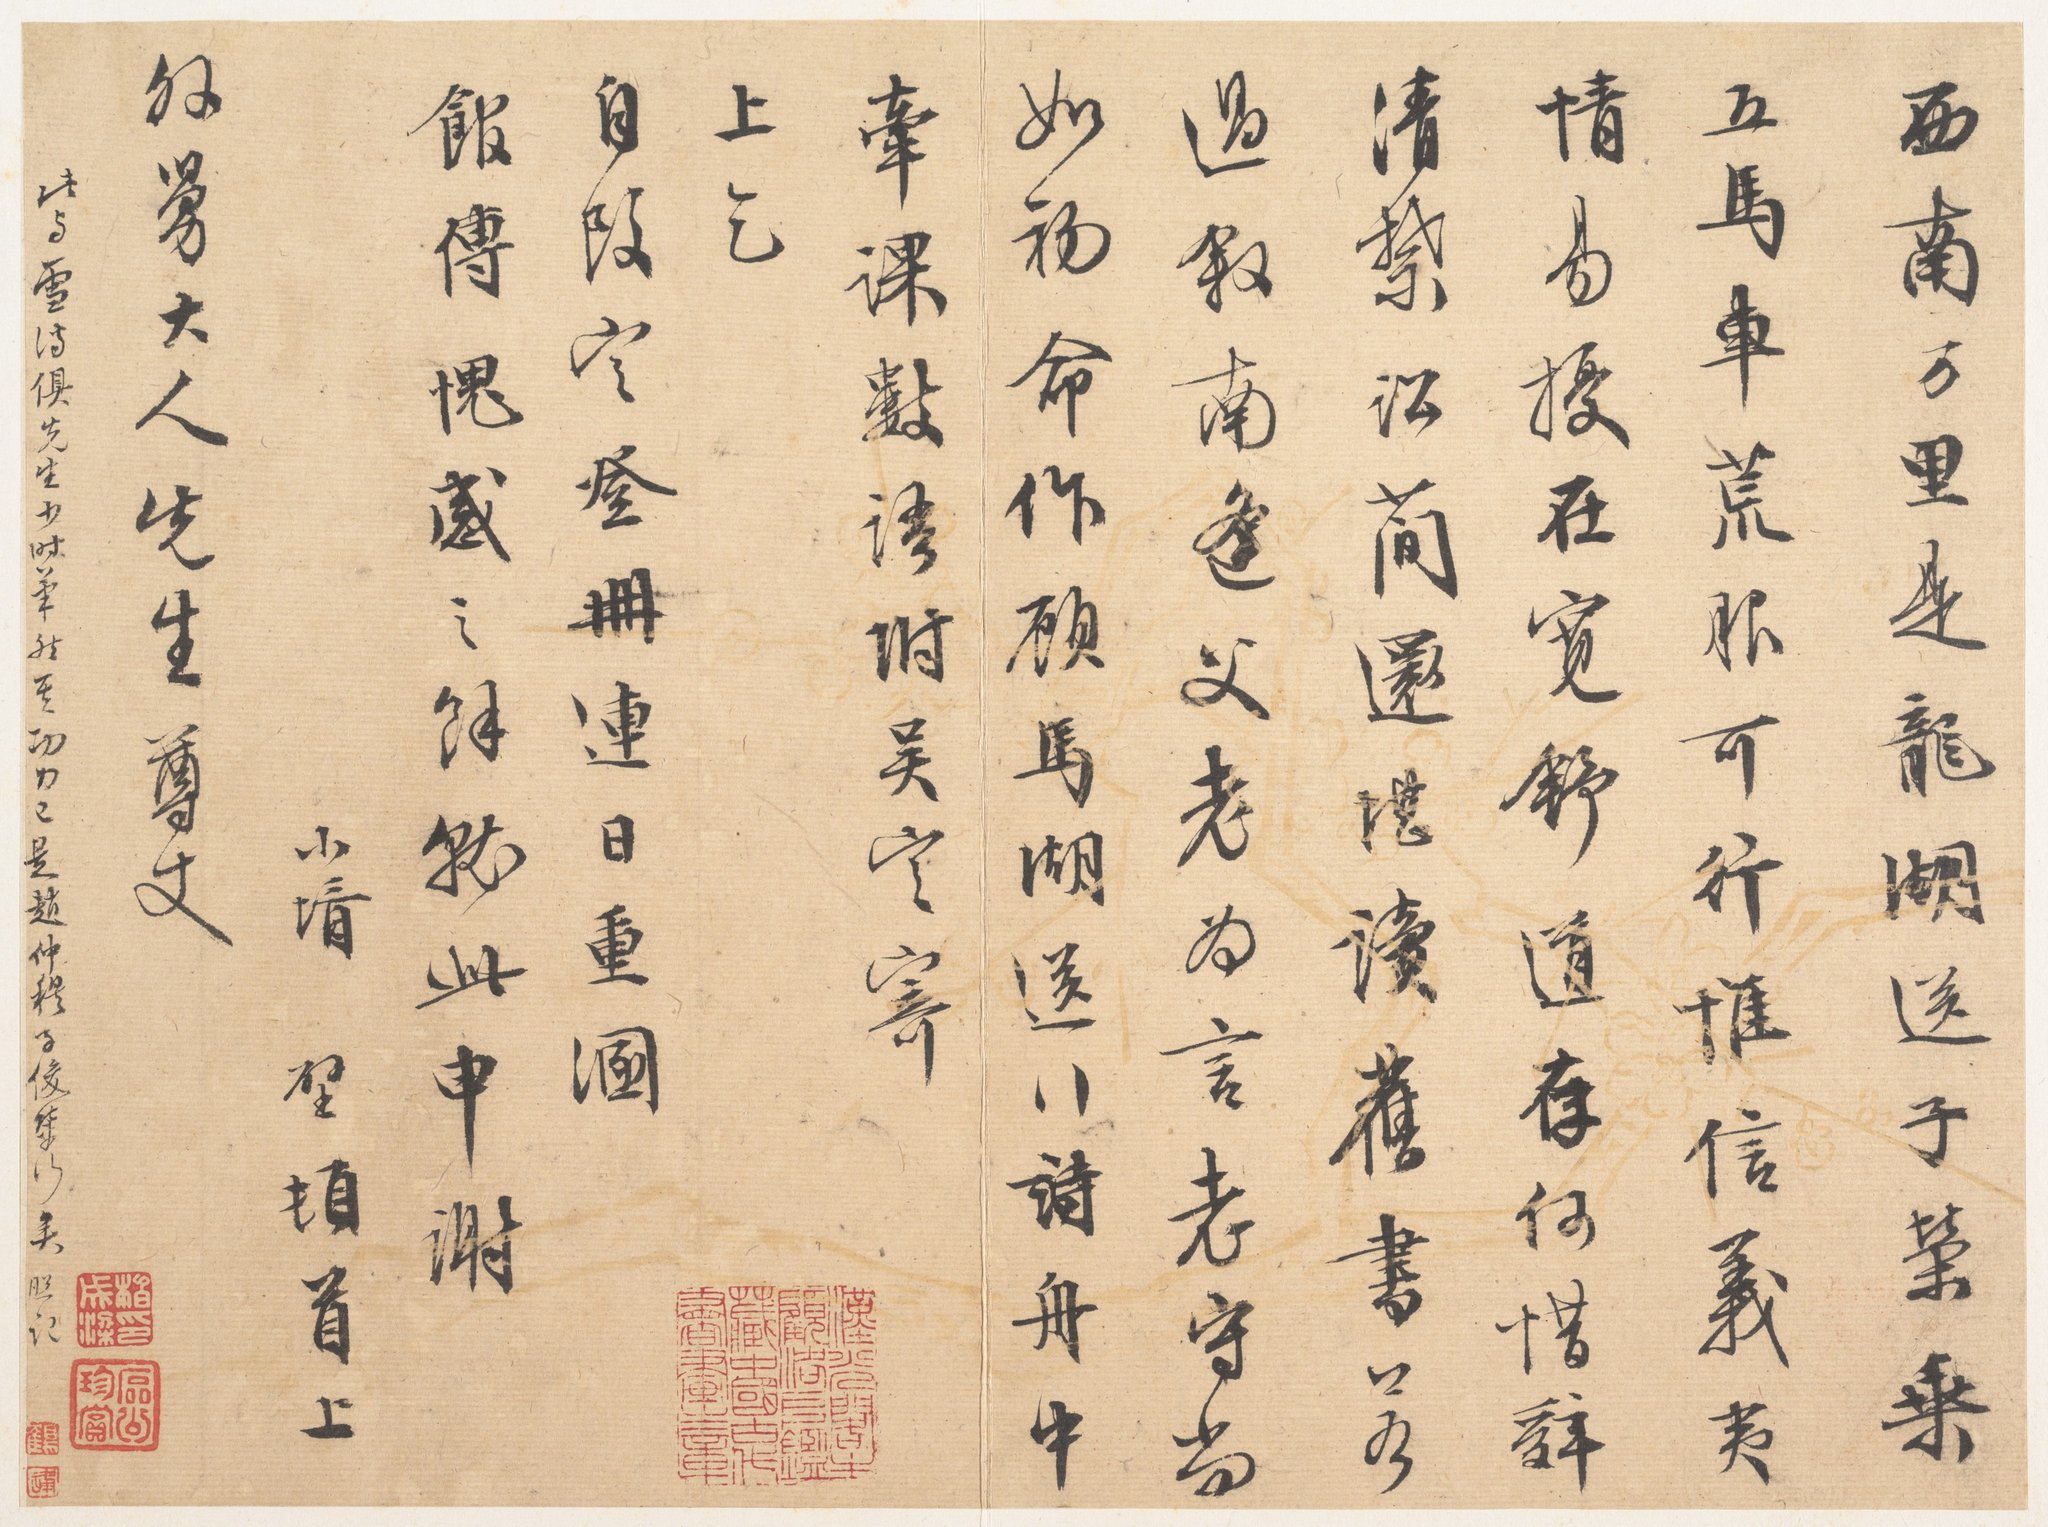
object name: album leaf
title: Letter to the artist’s father-in-law, Wu Yu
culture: chinese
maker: wen zhengming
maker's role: artist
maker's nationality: chinese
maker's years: 1470-1559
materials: ink, paper